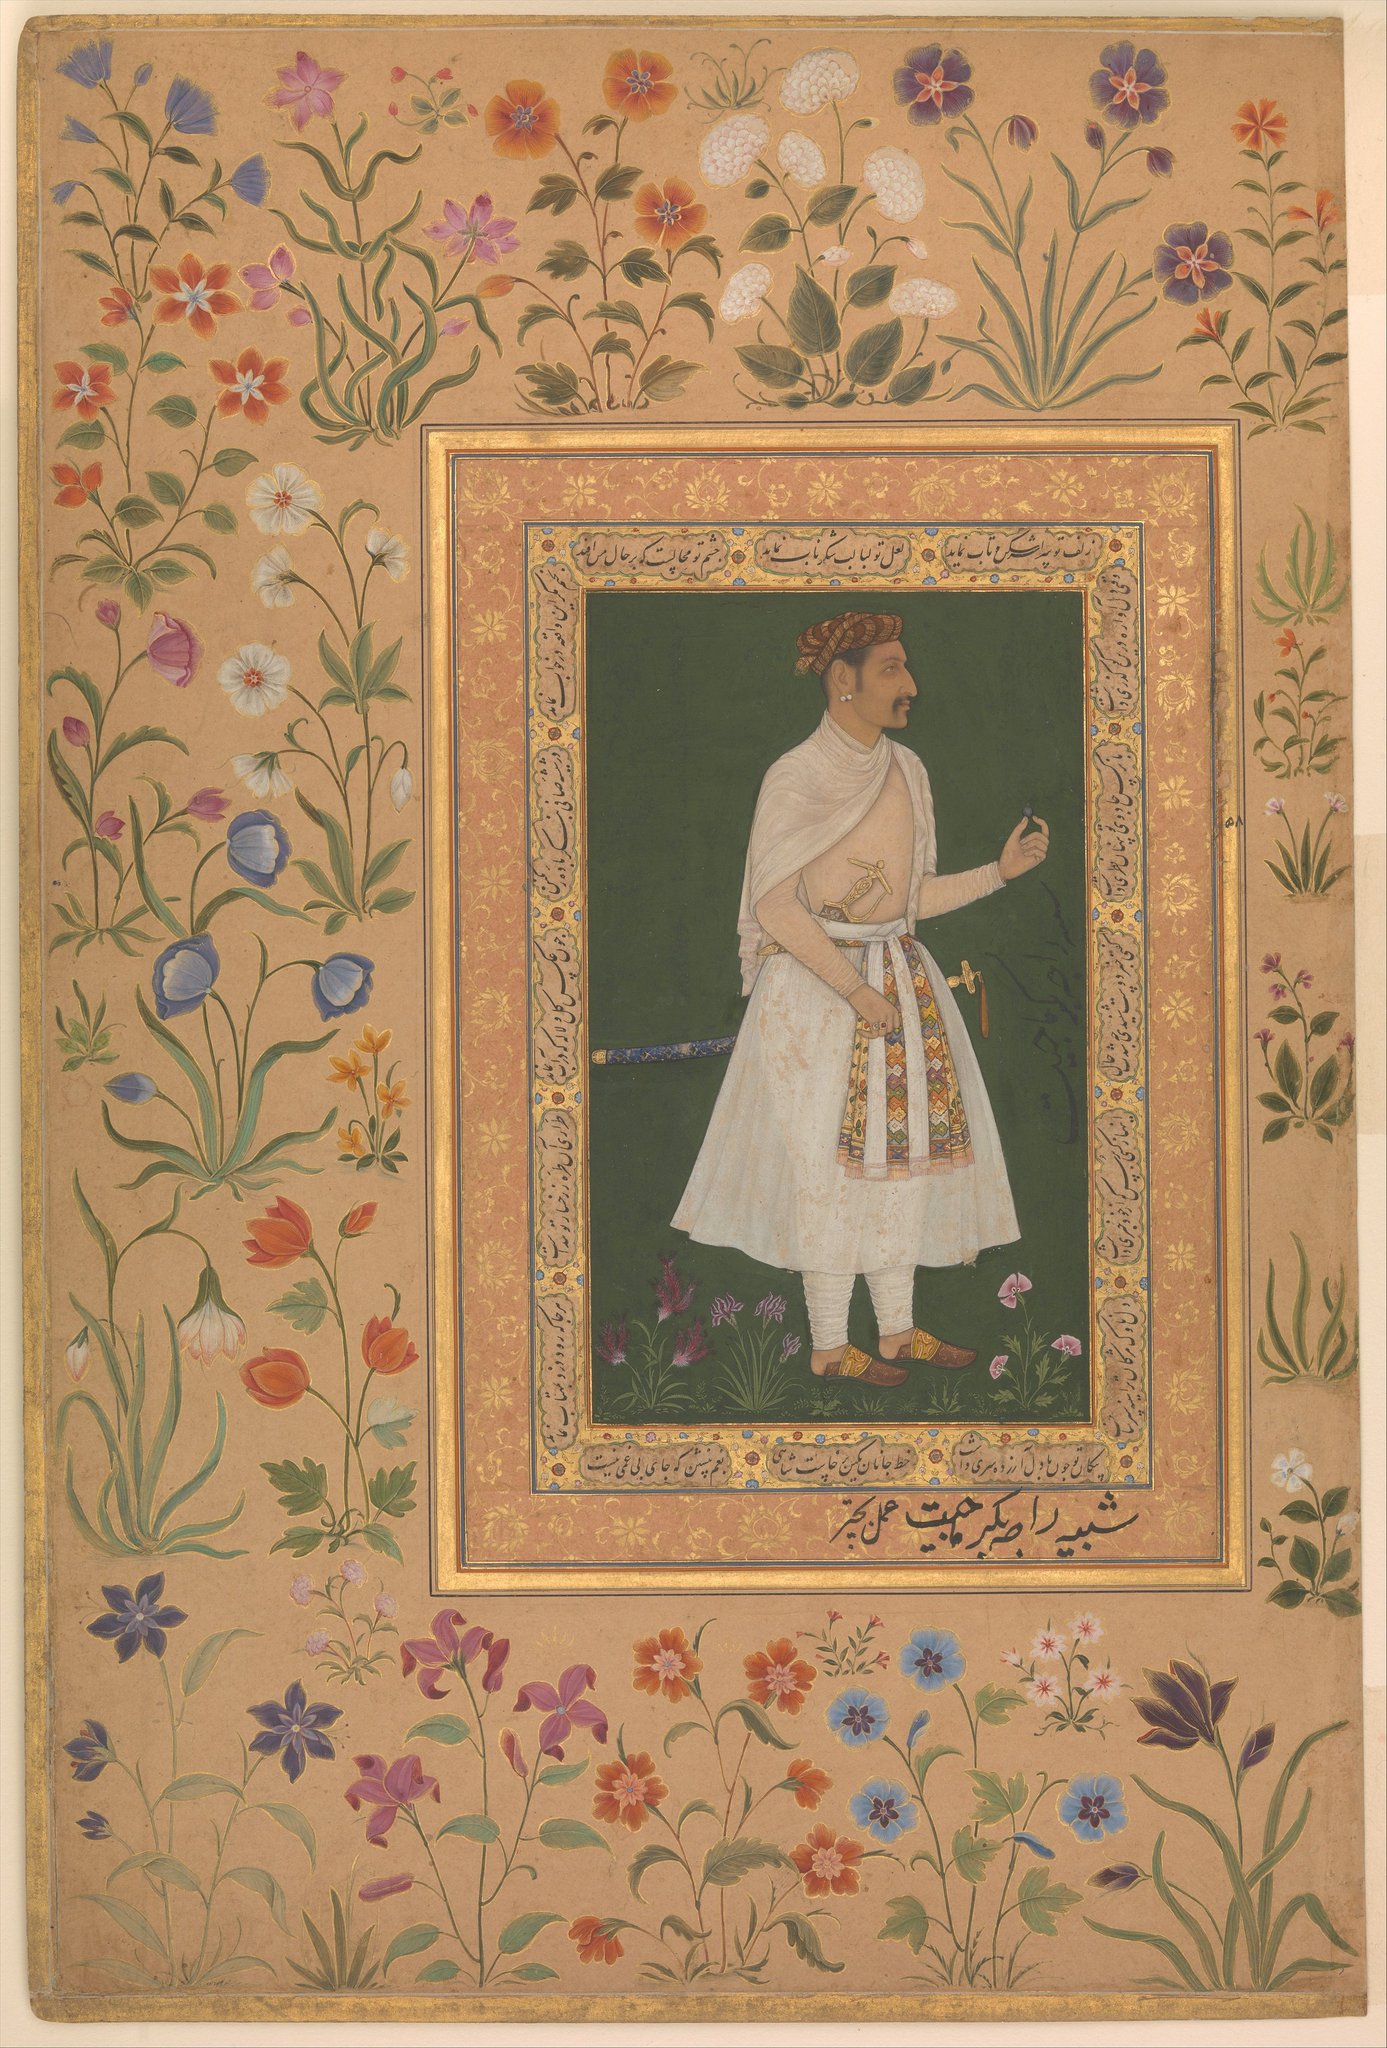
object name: album leaf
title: "Portrait of Raja Bikramajit (Sundar Das)", Folio from the Shah Jahan Album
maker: bichitr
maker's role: artist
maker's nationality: indian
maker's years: 1585-1685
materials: gold, ink, paper, watercolor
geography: india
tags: kings,portraits,flowers